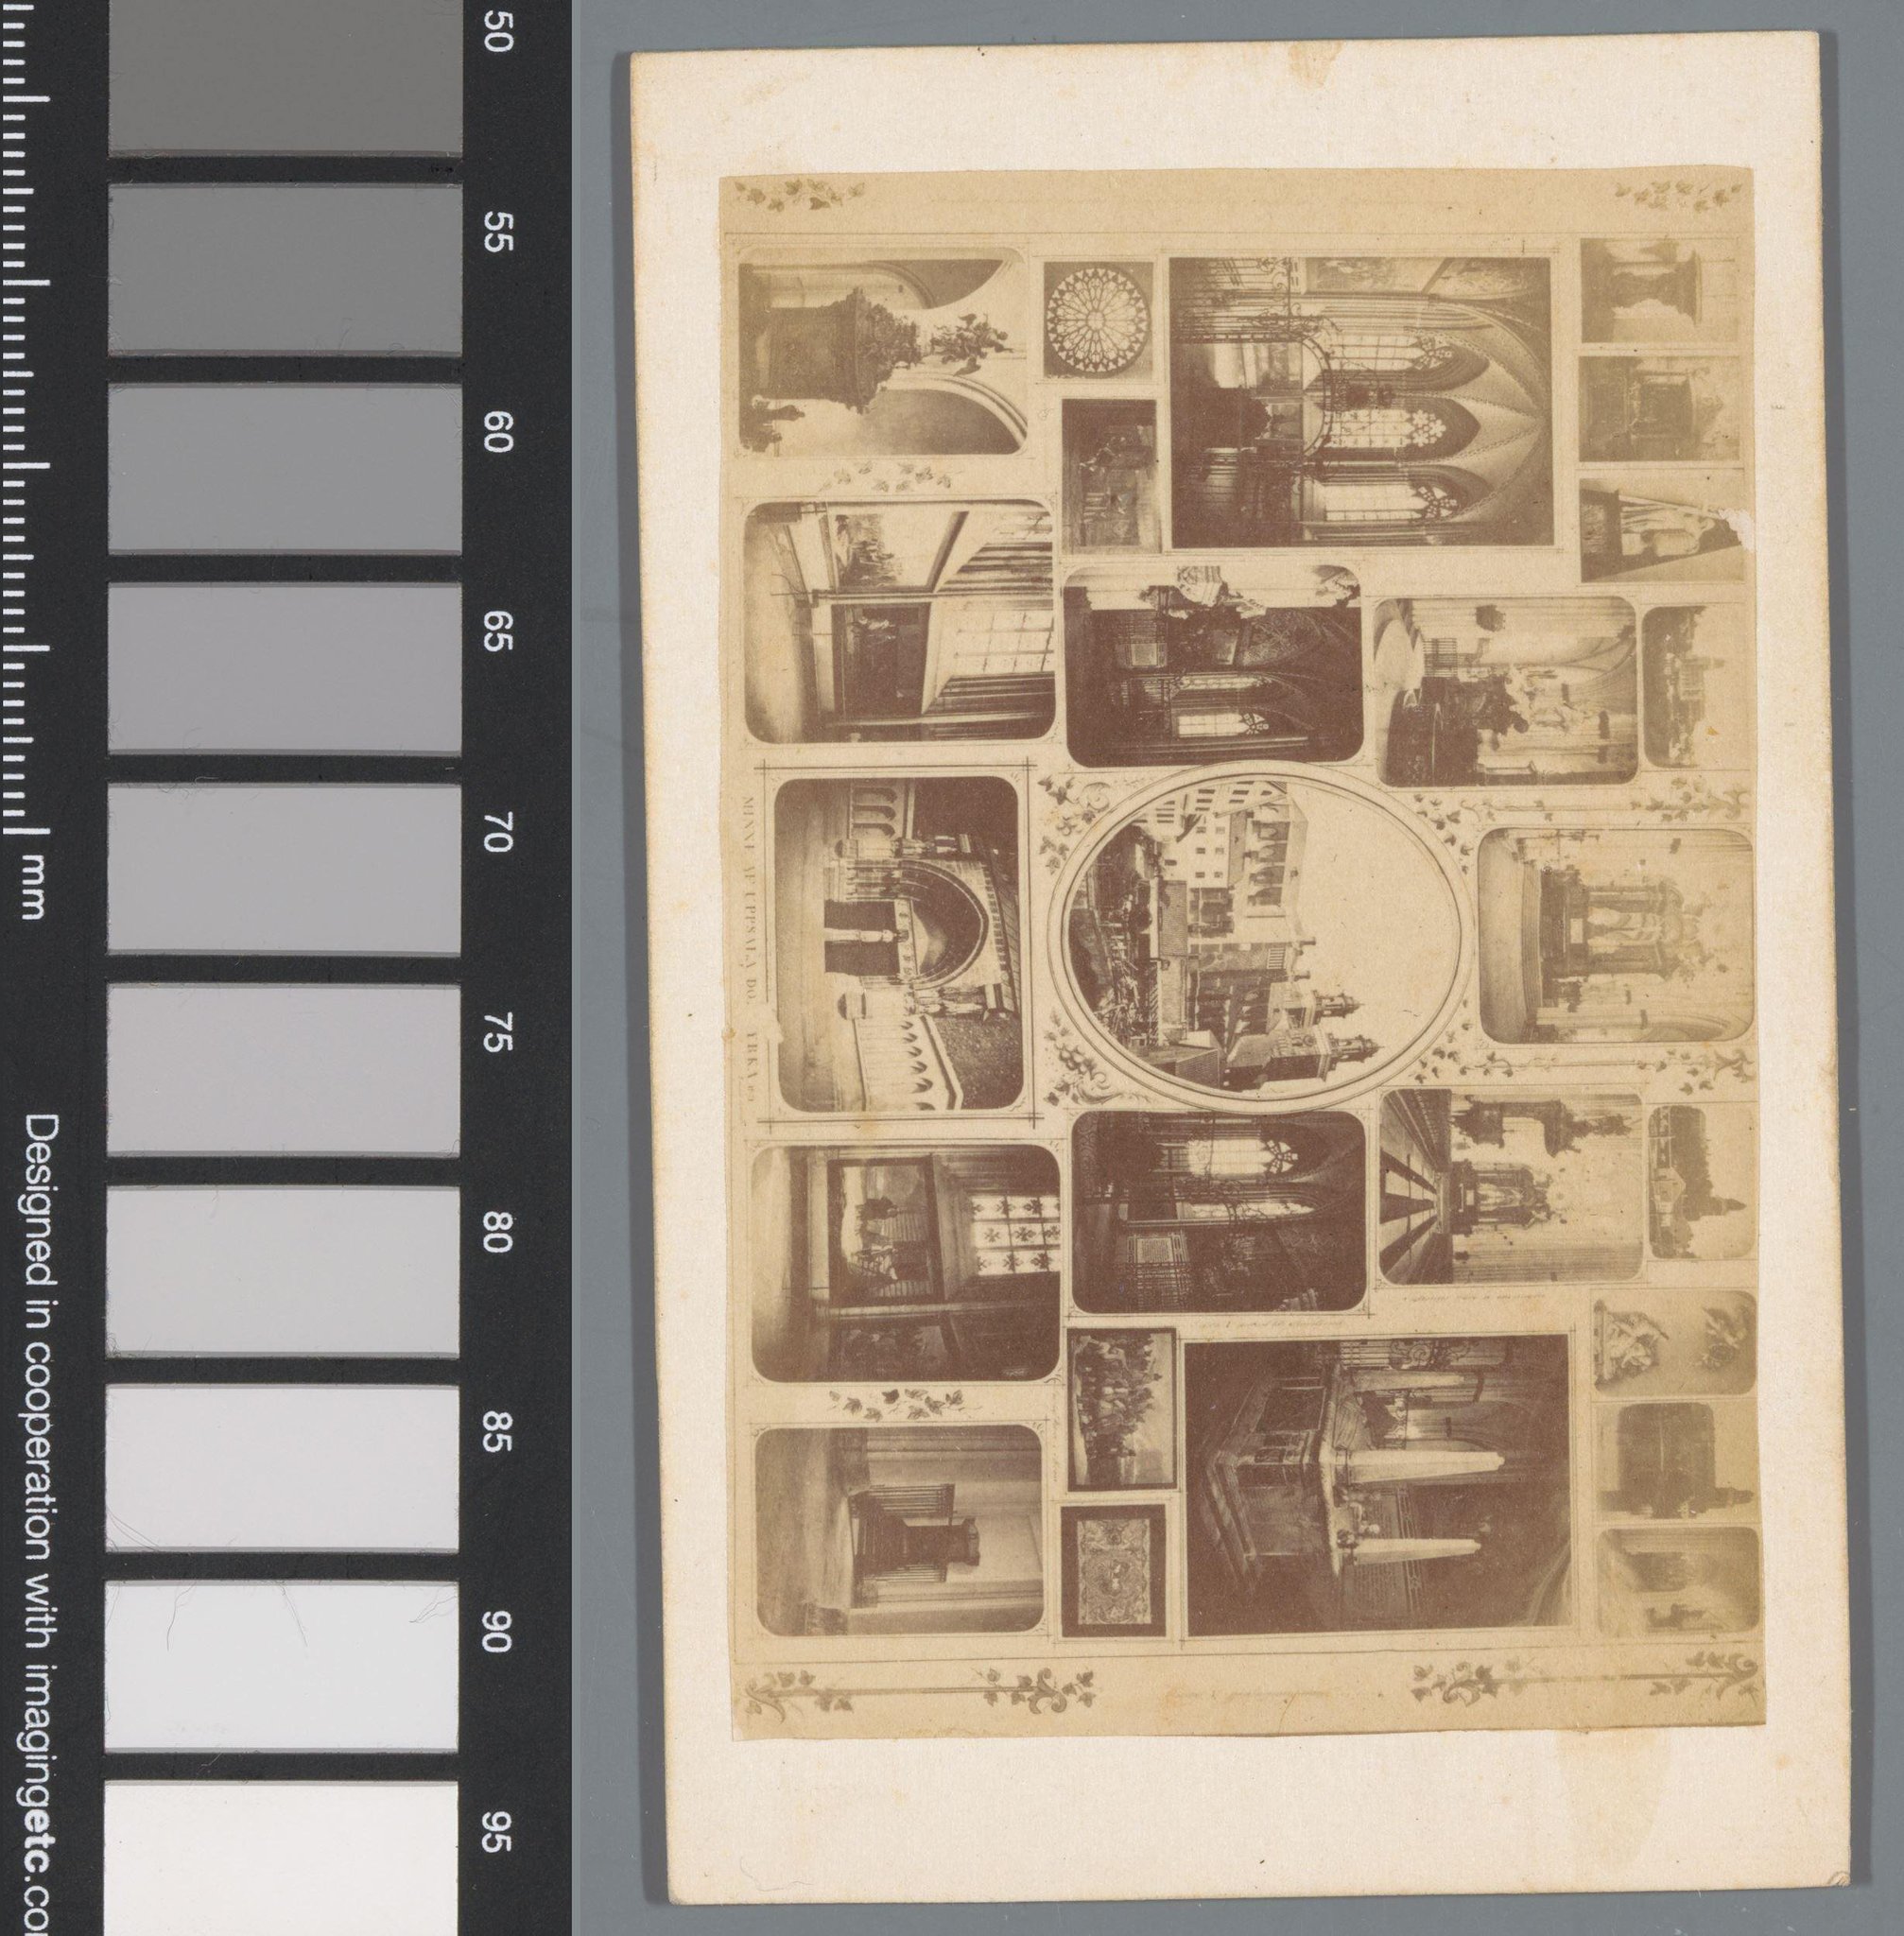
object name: carte de visite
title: Fotoreproductie van foto's van de kathedraal van Uppsala, bedoeld als souvenir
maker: Anonymous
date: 1855-1885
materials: cardboard, paper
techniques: albumen print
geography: uppsala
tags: church (exterior), interior of church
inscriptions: inscription: ‘Upsal.’